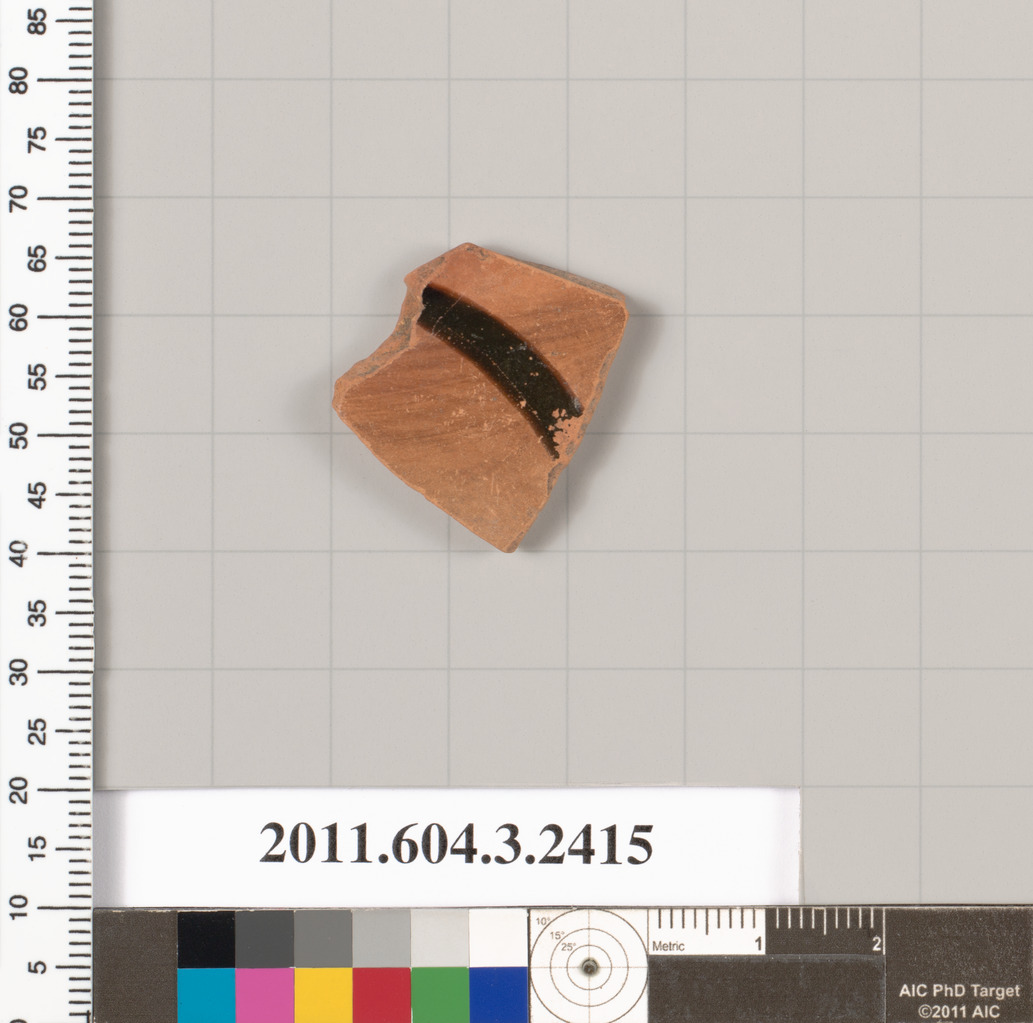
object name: kylix fragment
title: Terracotta fragment of a kylix: eye-cup (drinking cup)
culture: greek, attic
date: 530-510 BCE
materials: terracotta